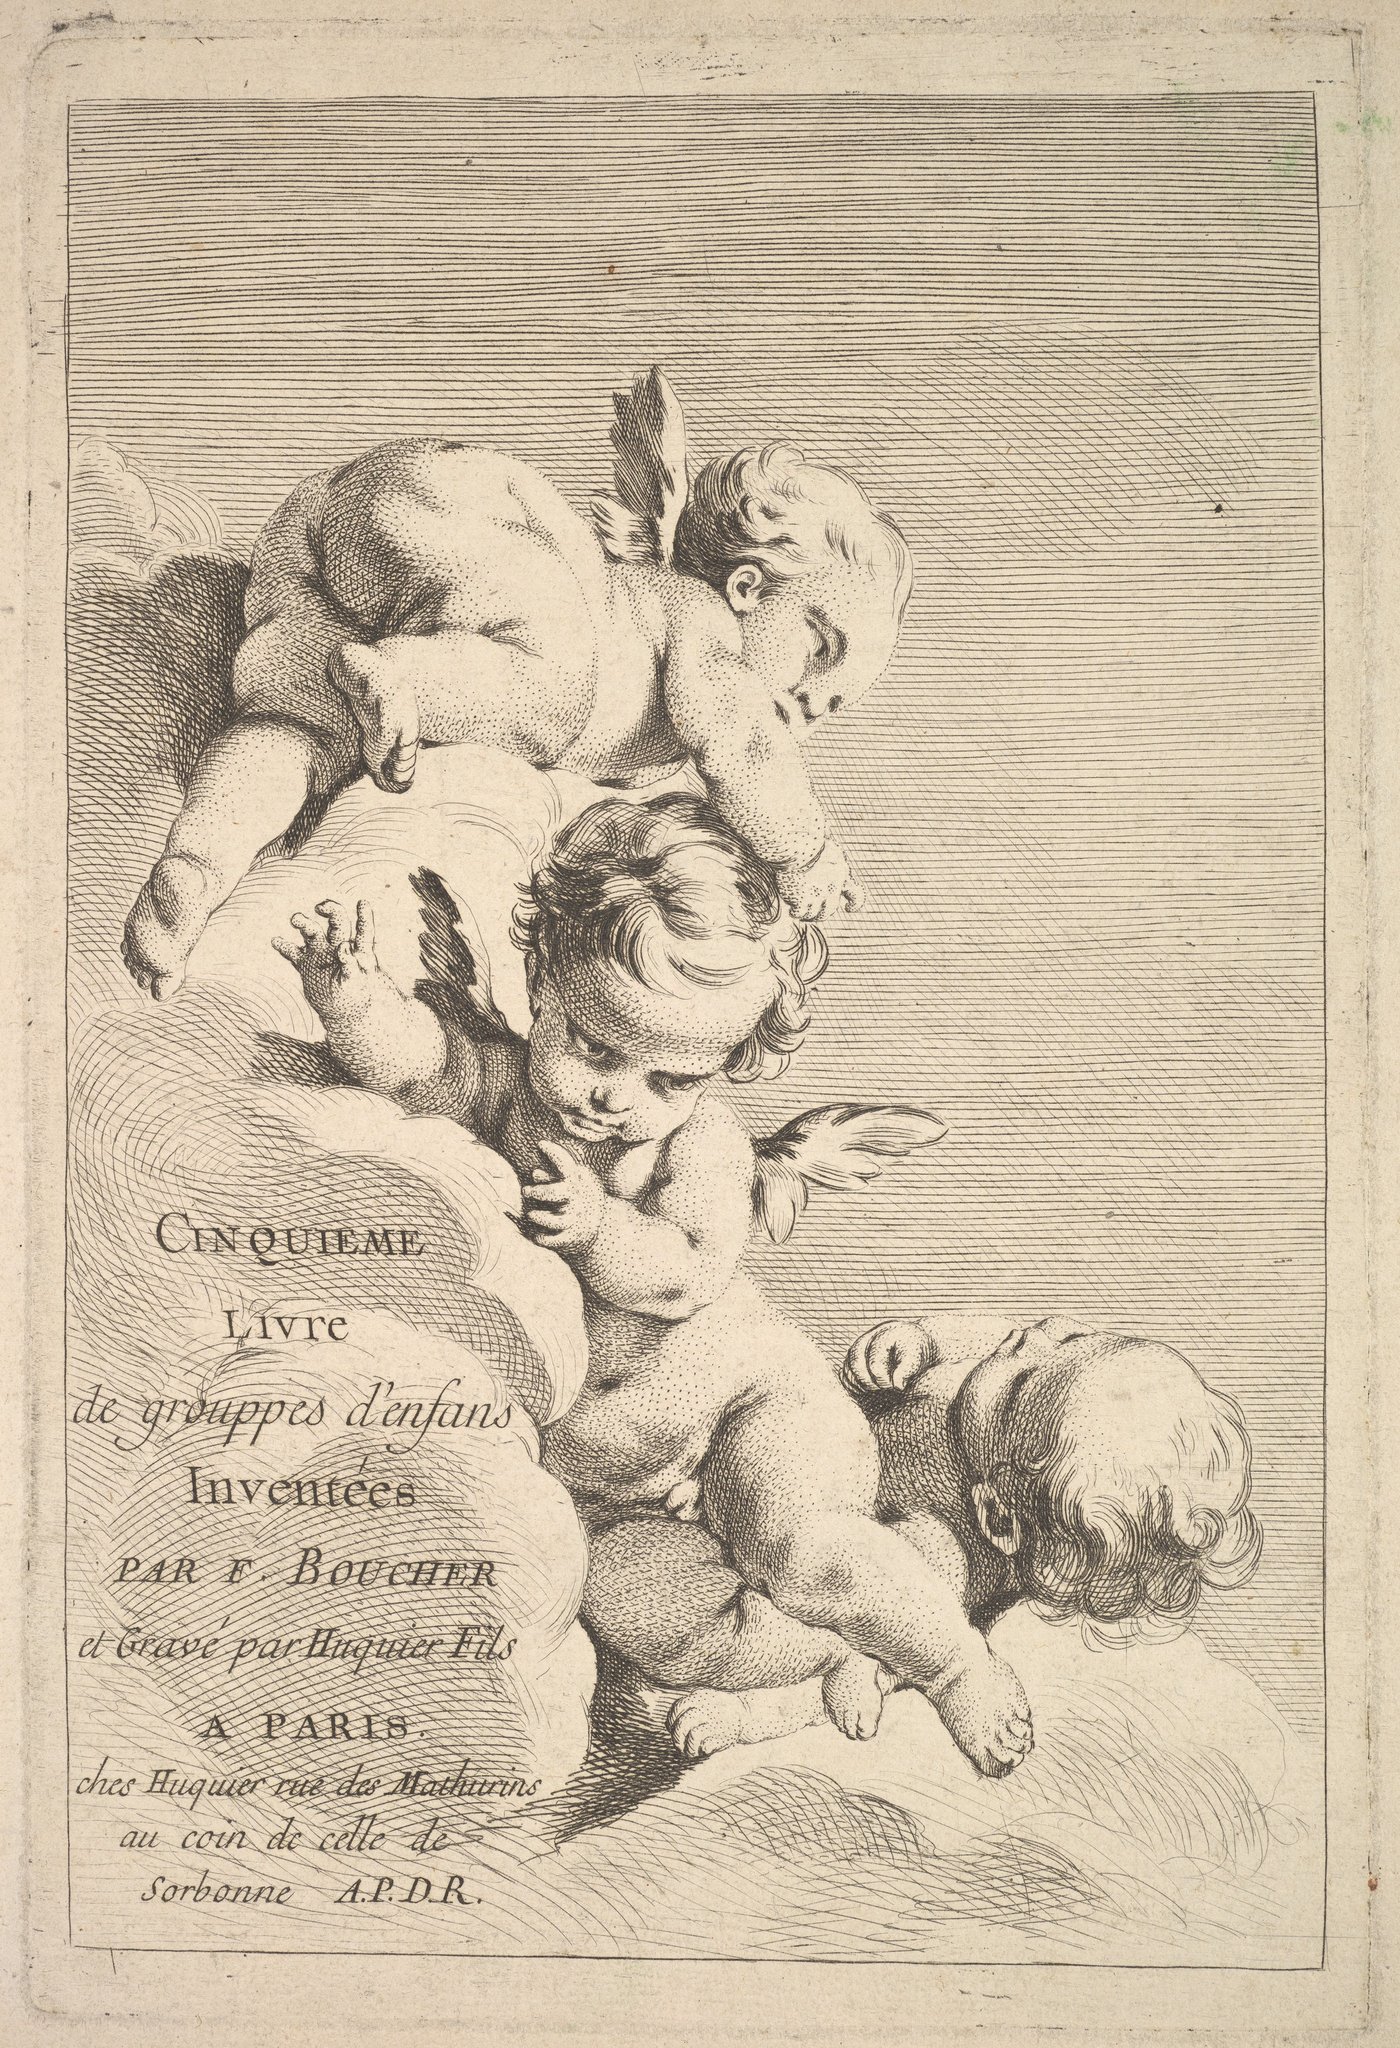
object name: print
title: Frontispiece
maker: jacques gabriel huquier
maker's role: artist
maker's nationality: french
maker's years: 1730-1805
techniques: engraving, etching